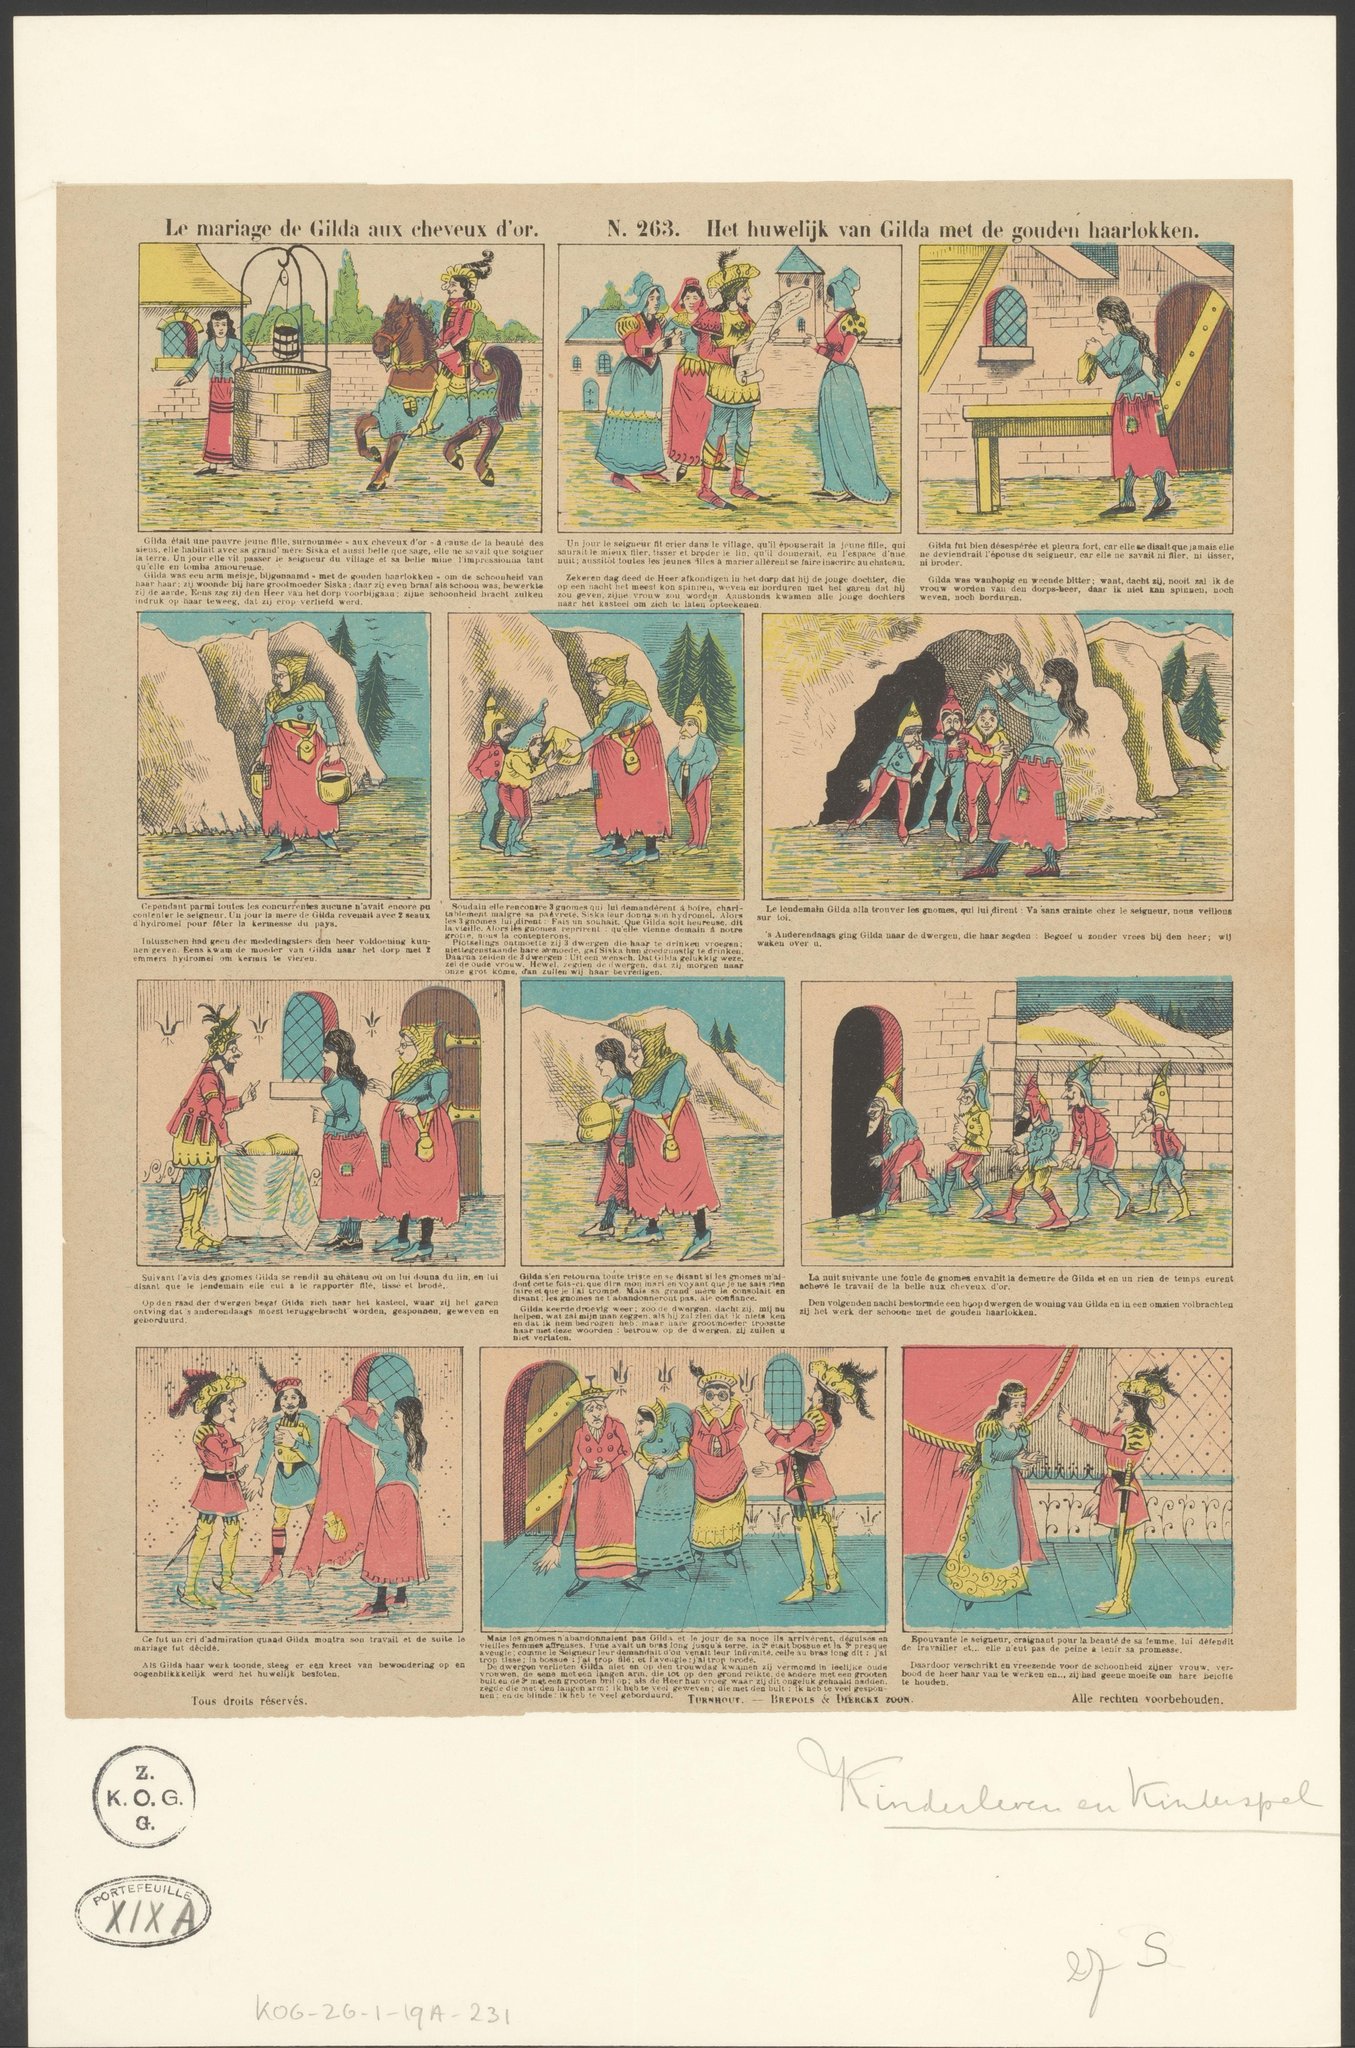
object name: print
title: Gilda met de gouden haarlokken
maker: Anonymous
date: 1833-1911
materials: paper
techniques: lithograph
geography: turnhout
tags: tales and fairy tales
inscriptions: stamp, collector's mark: Lugt 1641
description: Blad met veertien voorstellingen uit het verhaal over het meisje Gilda met de gouden haarlokken. Onder iedere voorstelling een tekst in het Nederlands en Frans. Bovenaan genummerd: N. 263. Onderwerpsrubrieken binnen de Atlas Zeden en Gewoonten: Zeden en Gewoonten in Engeren Zin, Des menschen beging, midden en einde, Kinderleven – Kinderspel en Kinderprenten.